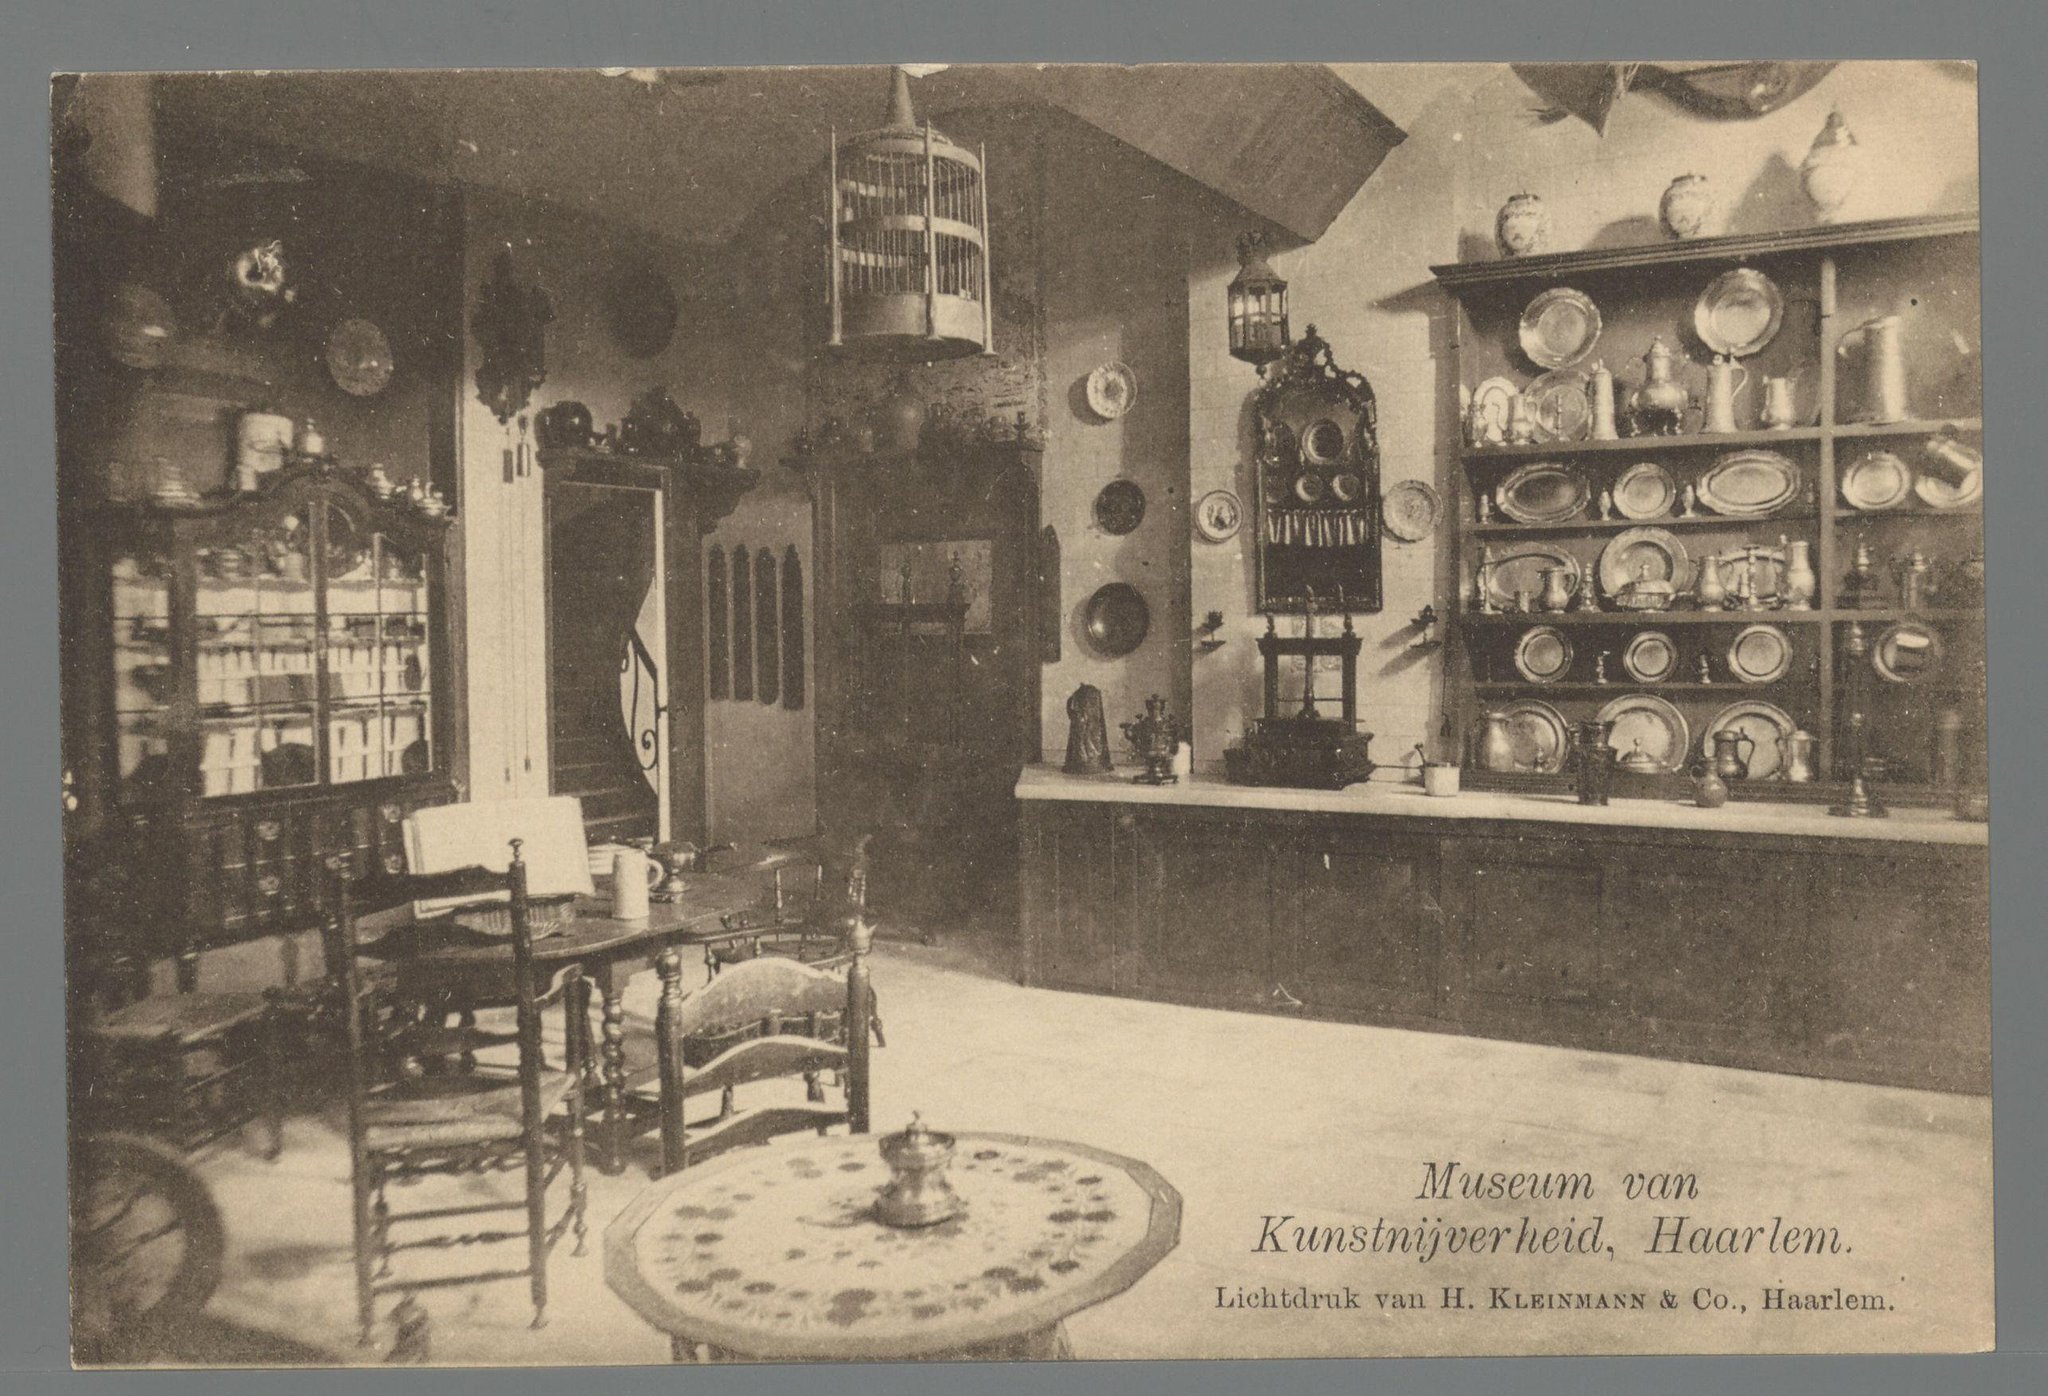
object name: photomechanical print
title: Museum van Kunstnijverheid, Haarlem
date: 1894-1905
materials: cardboard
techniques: photograph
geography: haarlem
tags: interior of the house, permanent exhibition, museum, haarlem